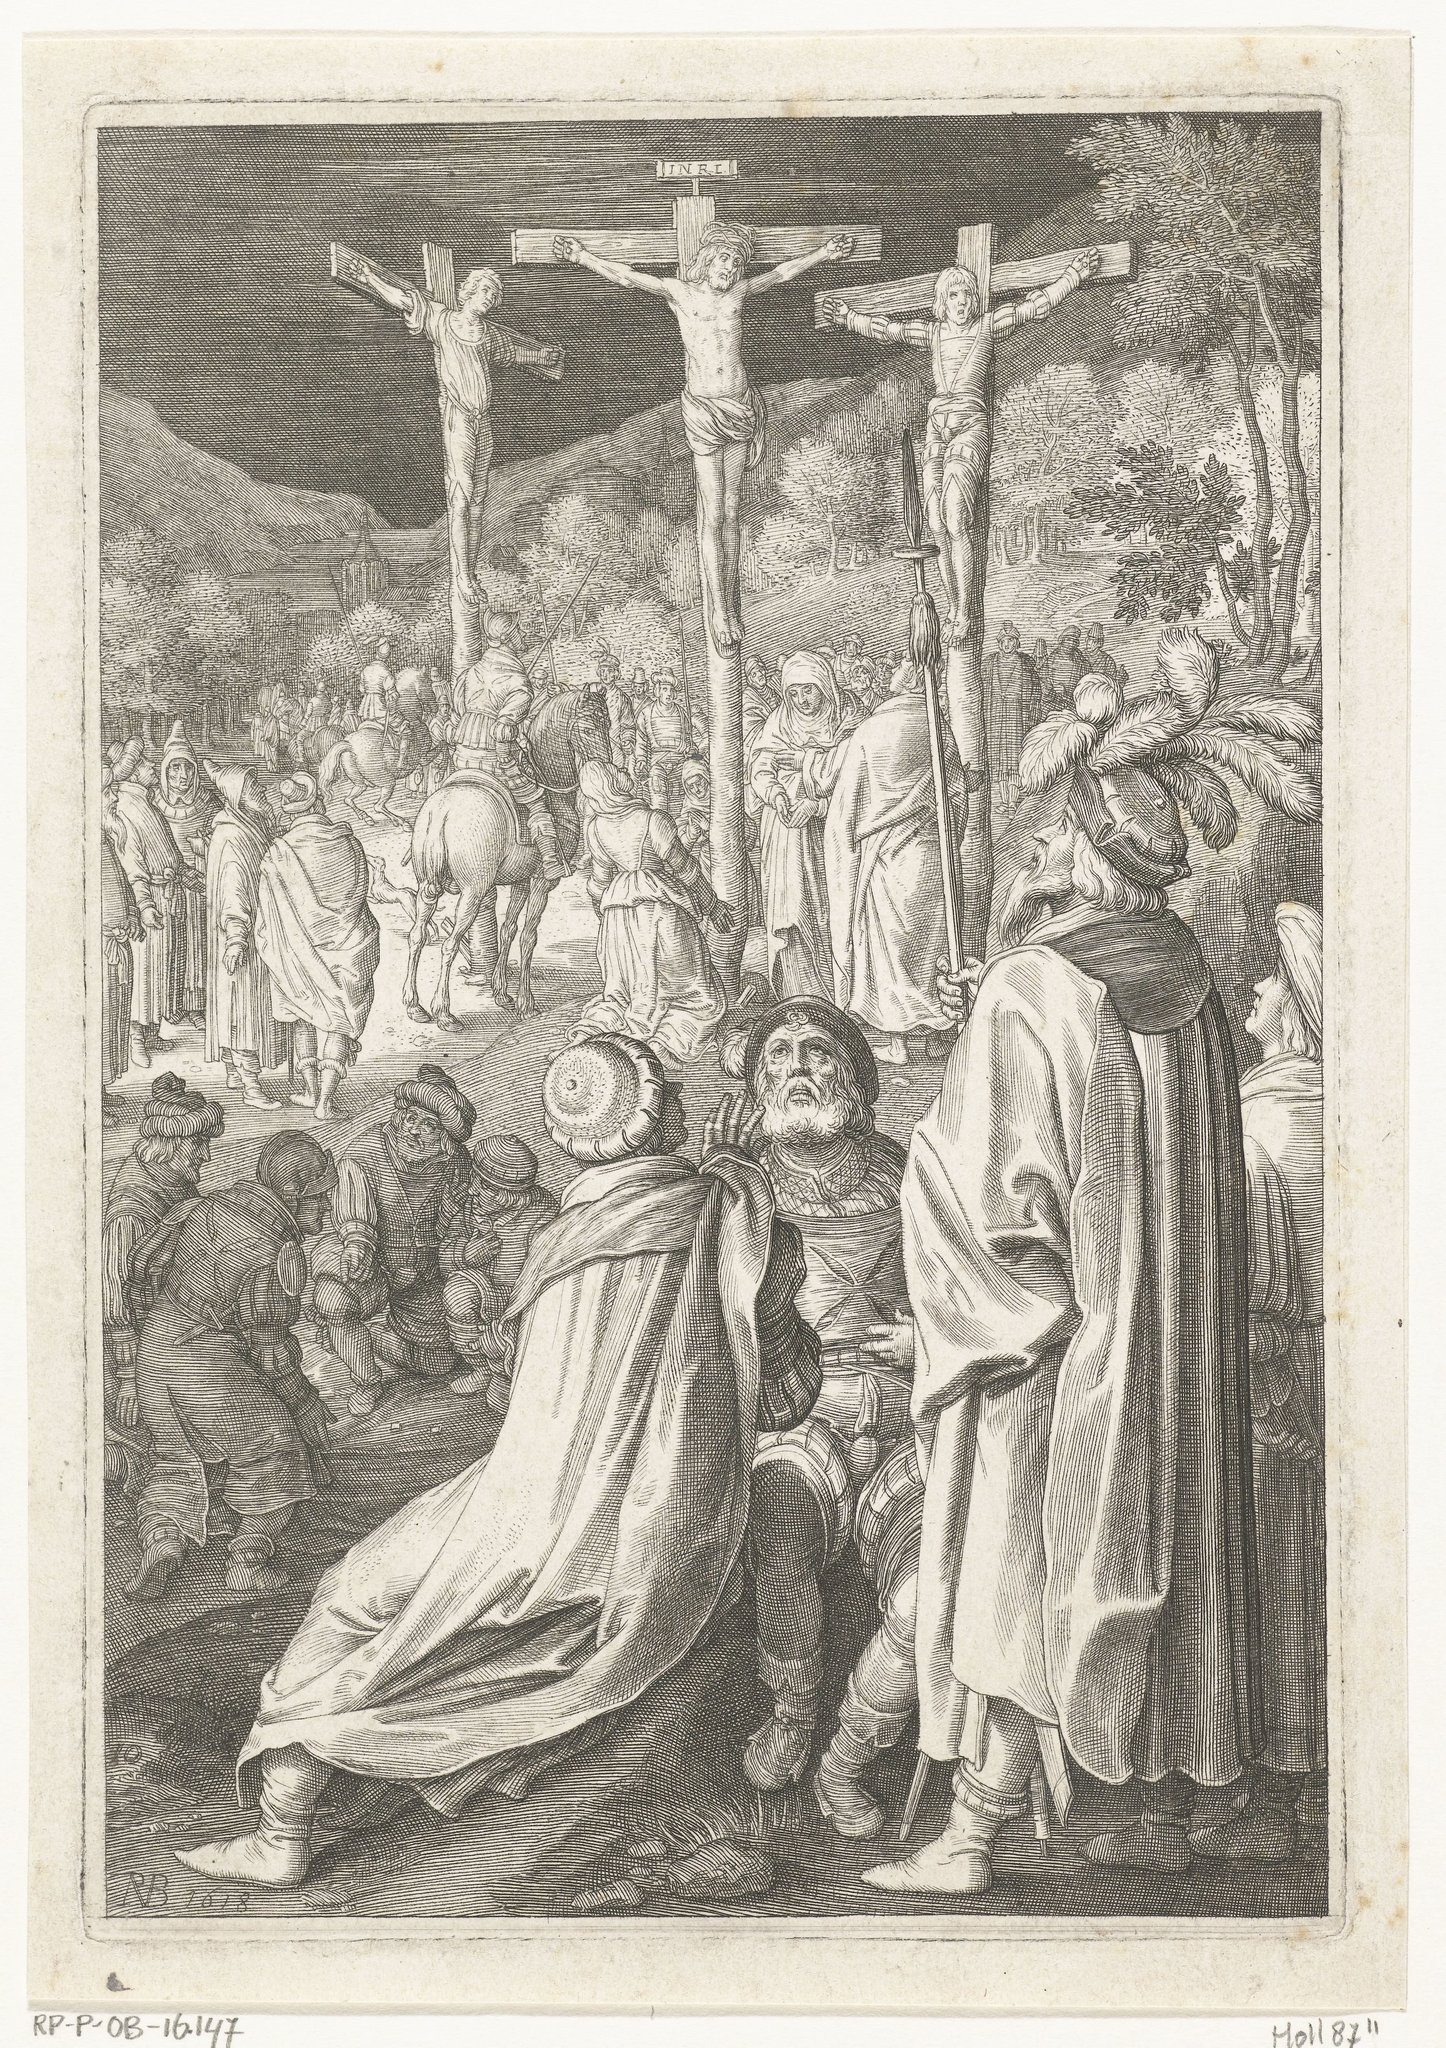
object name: print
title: Kruisiging van Christus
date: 1618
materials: paper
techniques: engraving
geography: netherlands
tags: the cross(es) in the middle distance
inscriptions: collector's mark: Lugt 2228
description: Prent uit serie van twaalf prenten met scènes uit de Passie. Reeks geïnspireerd door de prenten van Hendrick Goltzius en Lucas van Leyden.